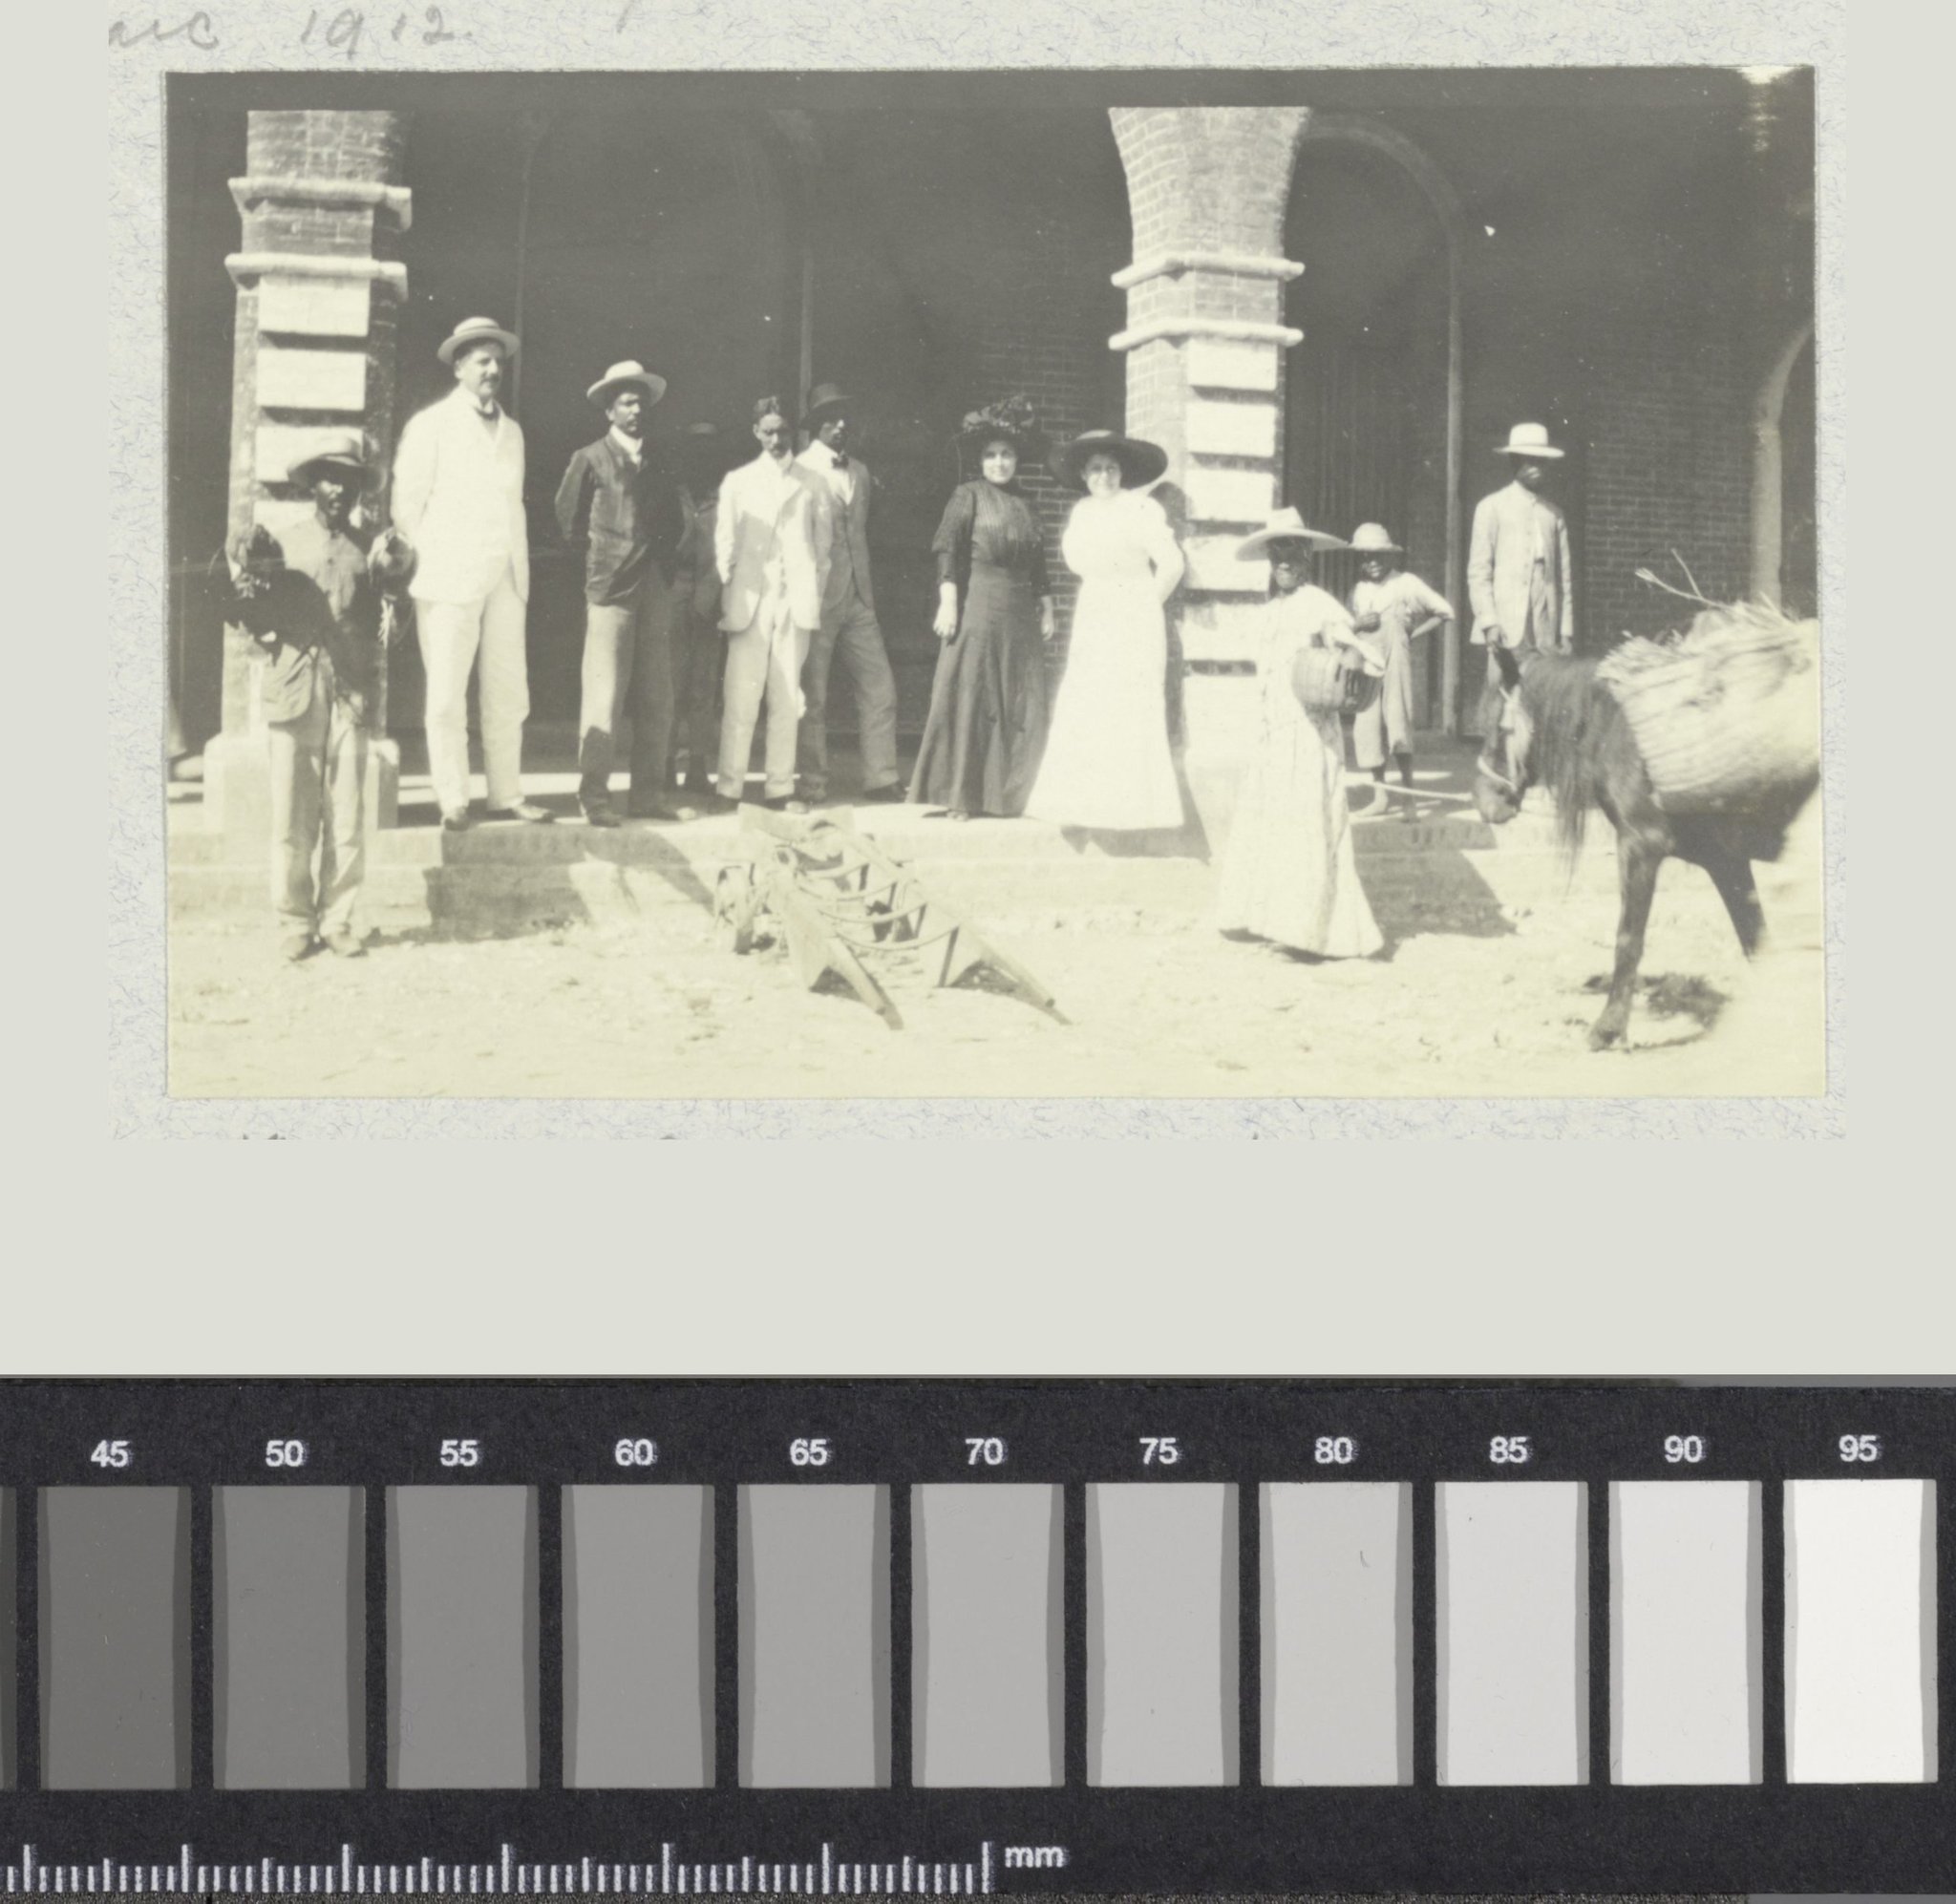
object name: photograph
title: Agentschap op Saint-Marc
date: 1901-1912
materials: photographic support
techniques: photography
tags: koninklijke west-indische maildienst, saint-marc, haïti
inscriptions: inscription: ‘Kantoor Agentschap St. Marc haïti / Jan. 1912’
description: Het personeel van het kantoor van de agentschap (van de K.W.I.M.) in Saint-Marc op Haïti, januari 1912. Onderdeel van het fotoalbum van de familie Boom-Gonggrijp in Suriname en Curaçao.